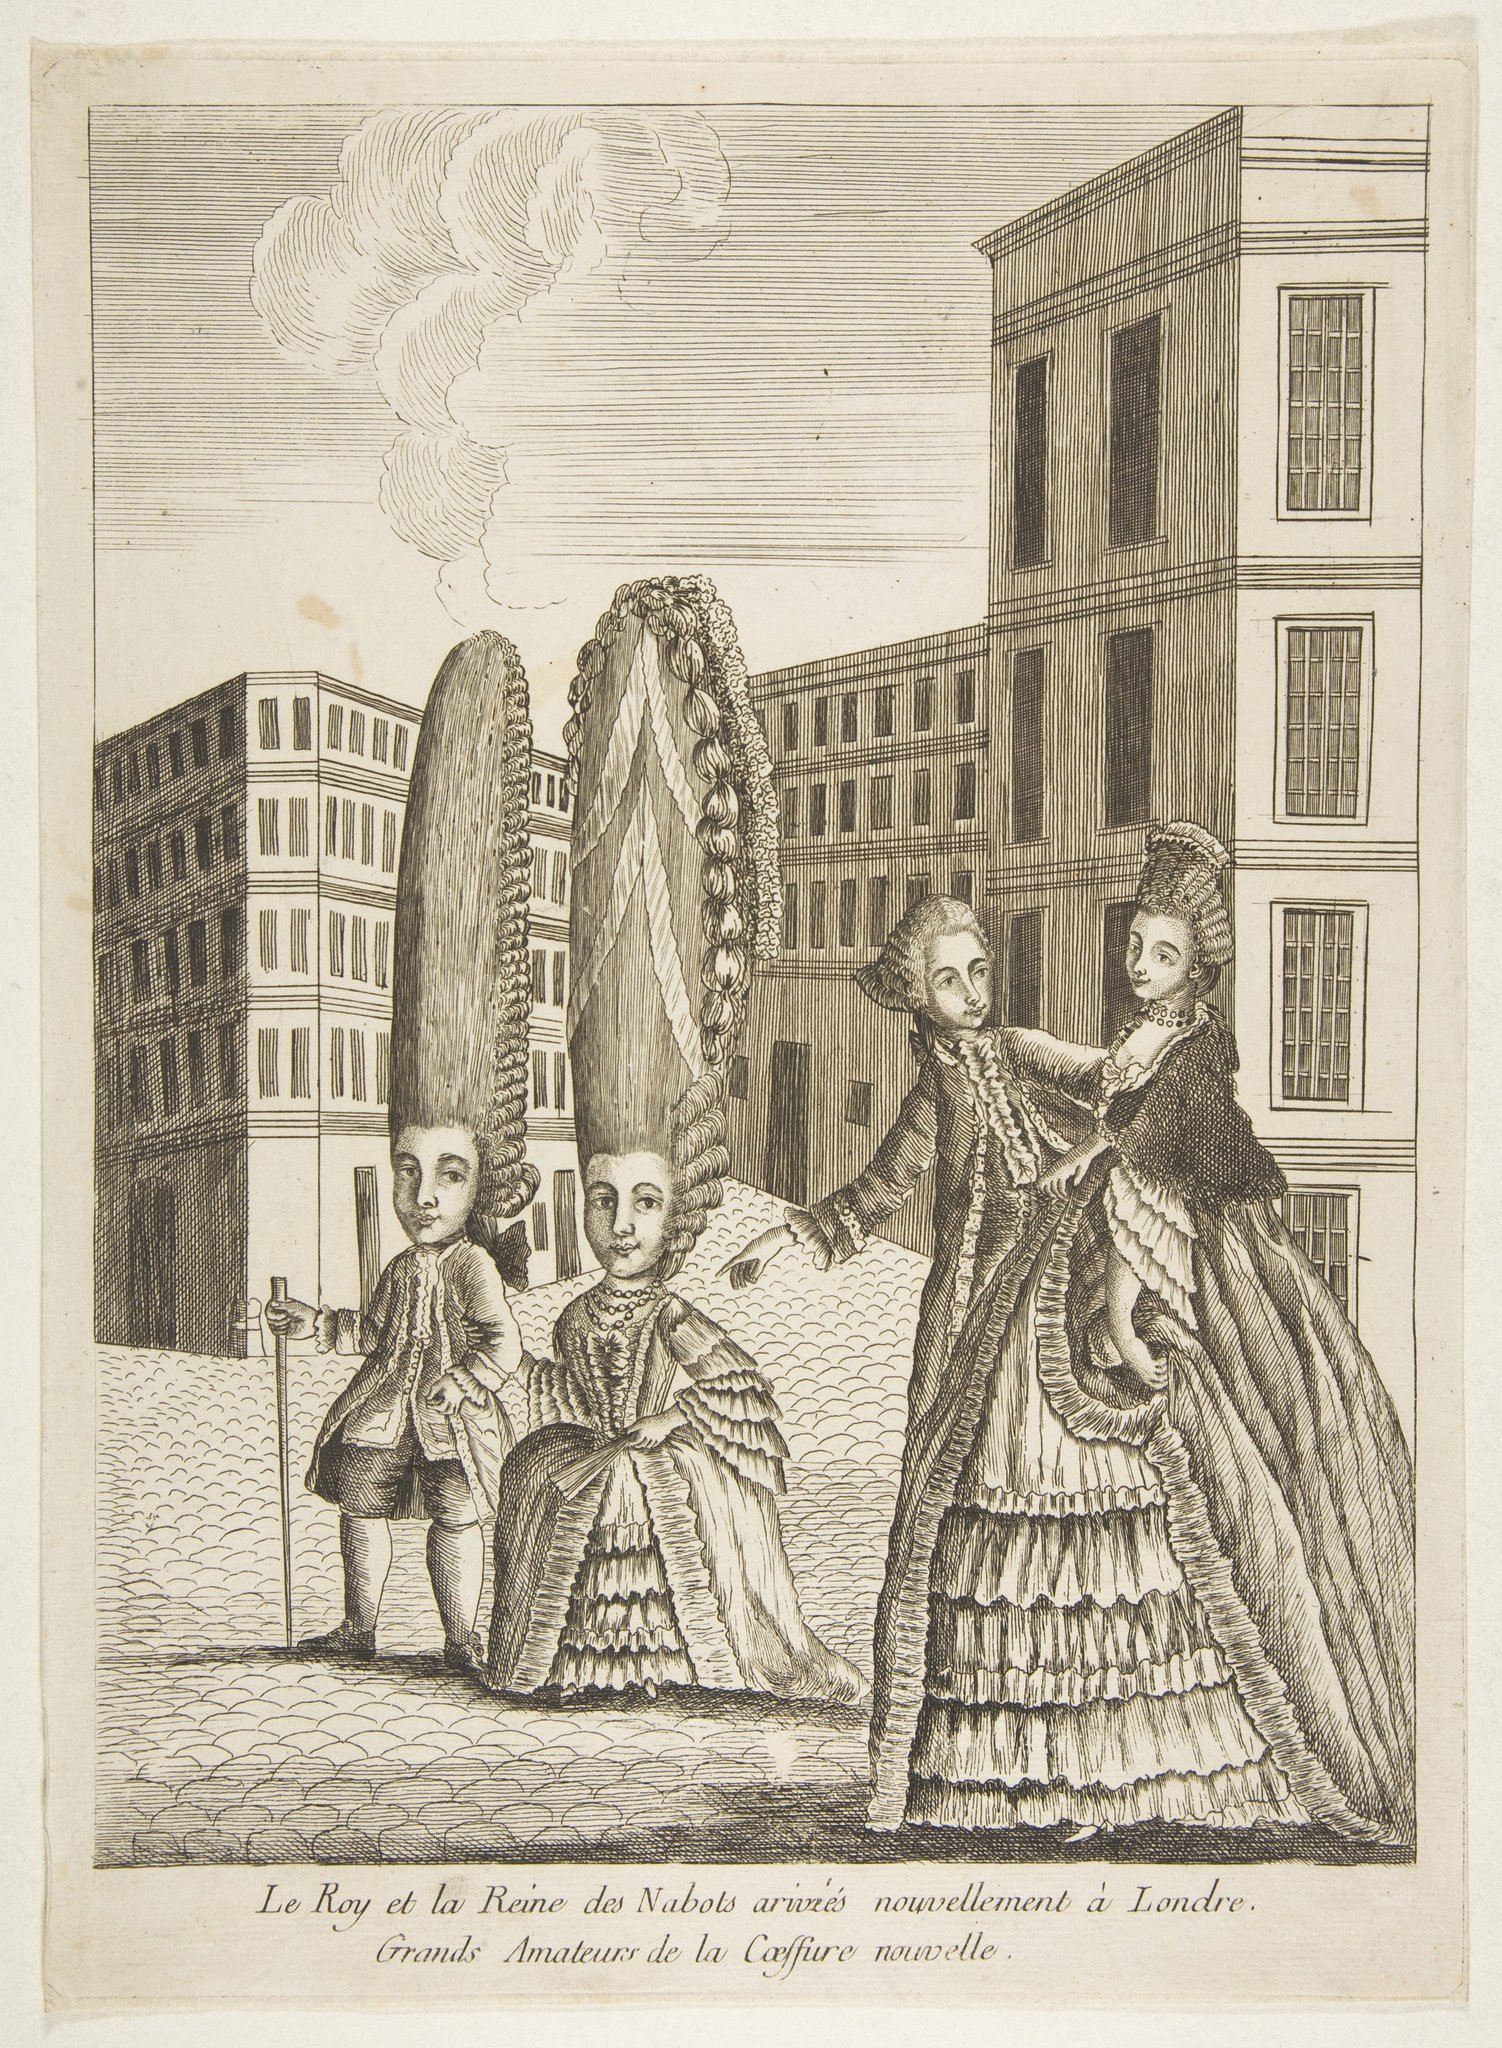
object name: print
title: Le Roy et la Reine des Nabots arrivés nouvellement à Londre. Grands amateurs de la coeffure nouvelle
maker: anonymous, french, 18th century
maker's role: artist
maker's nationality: french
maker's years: 1700-1800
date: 1701-1800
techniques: etching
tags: kings,queens,men,women,caricature